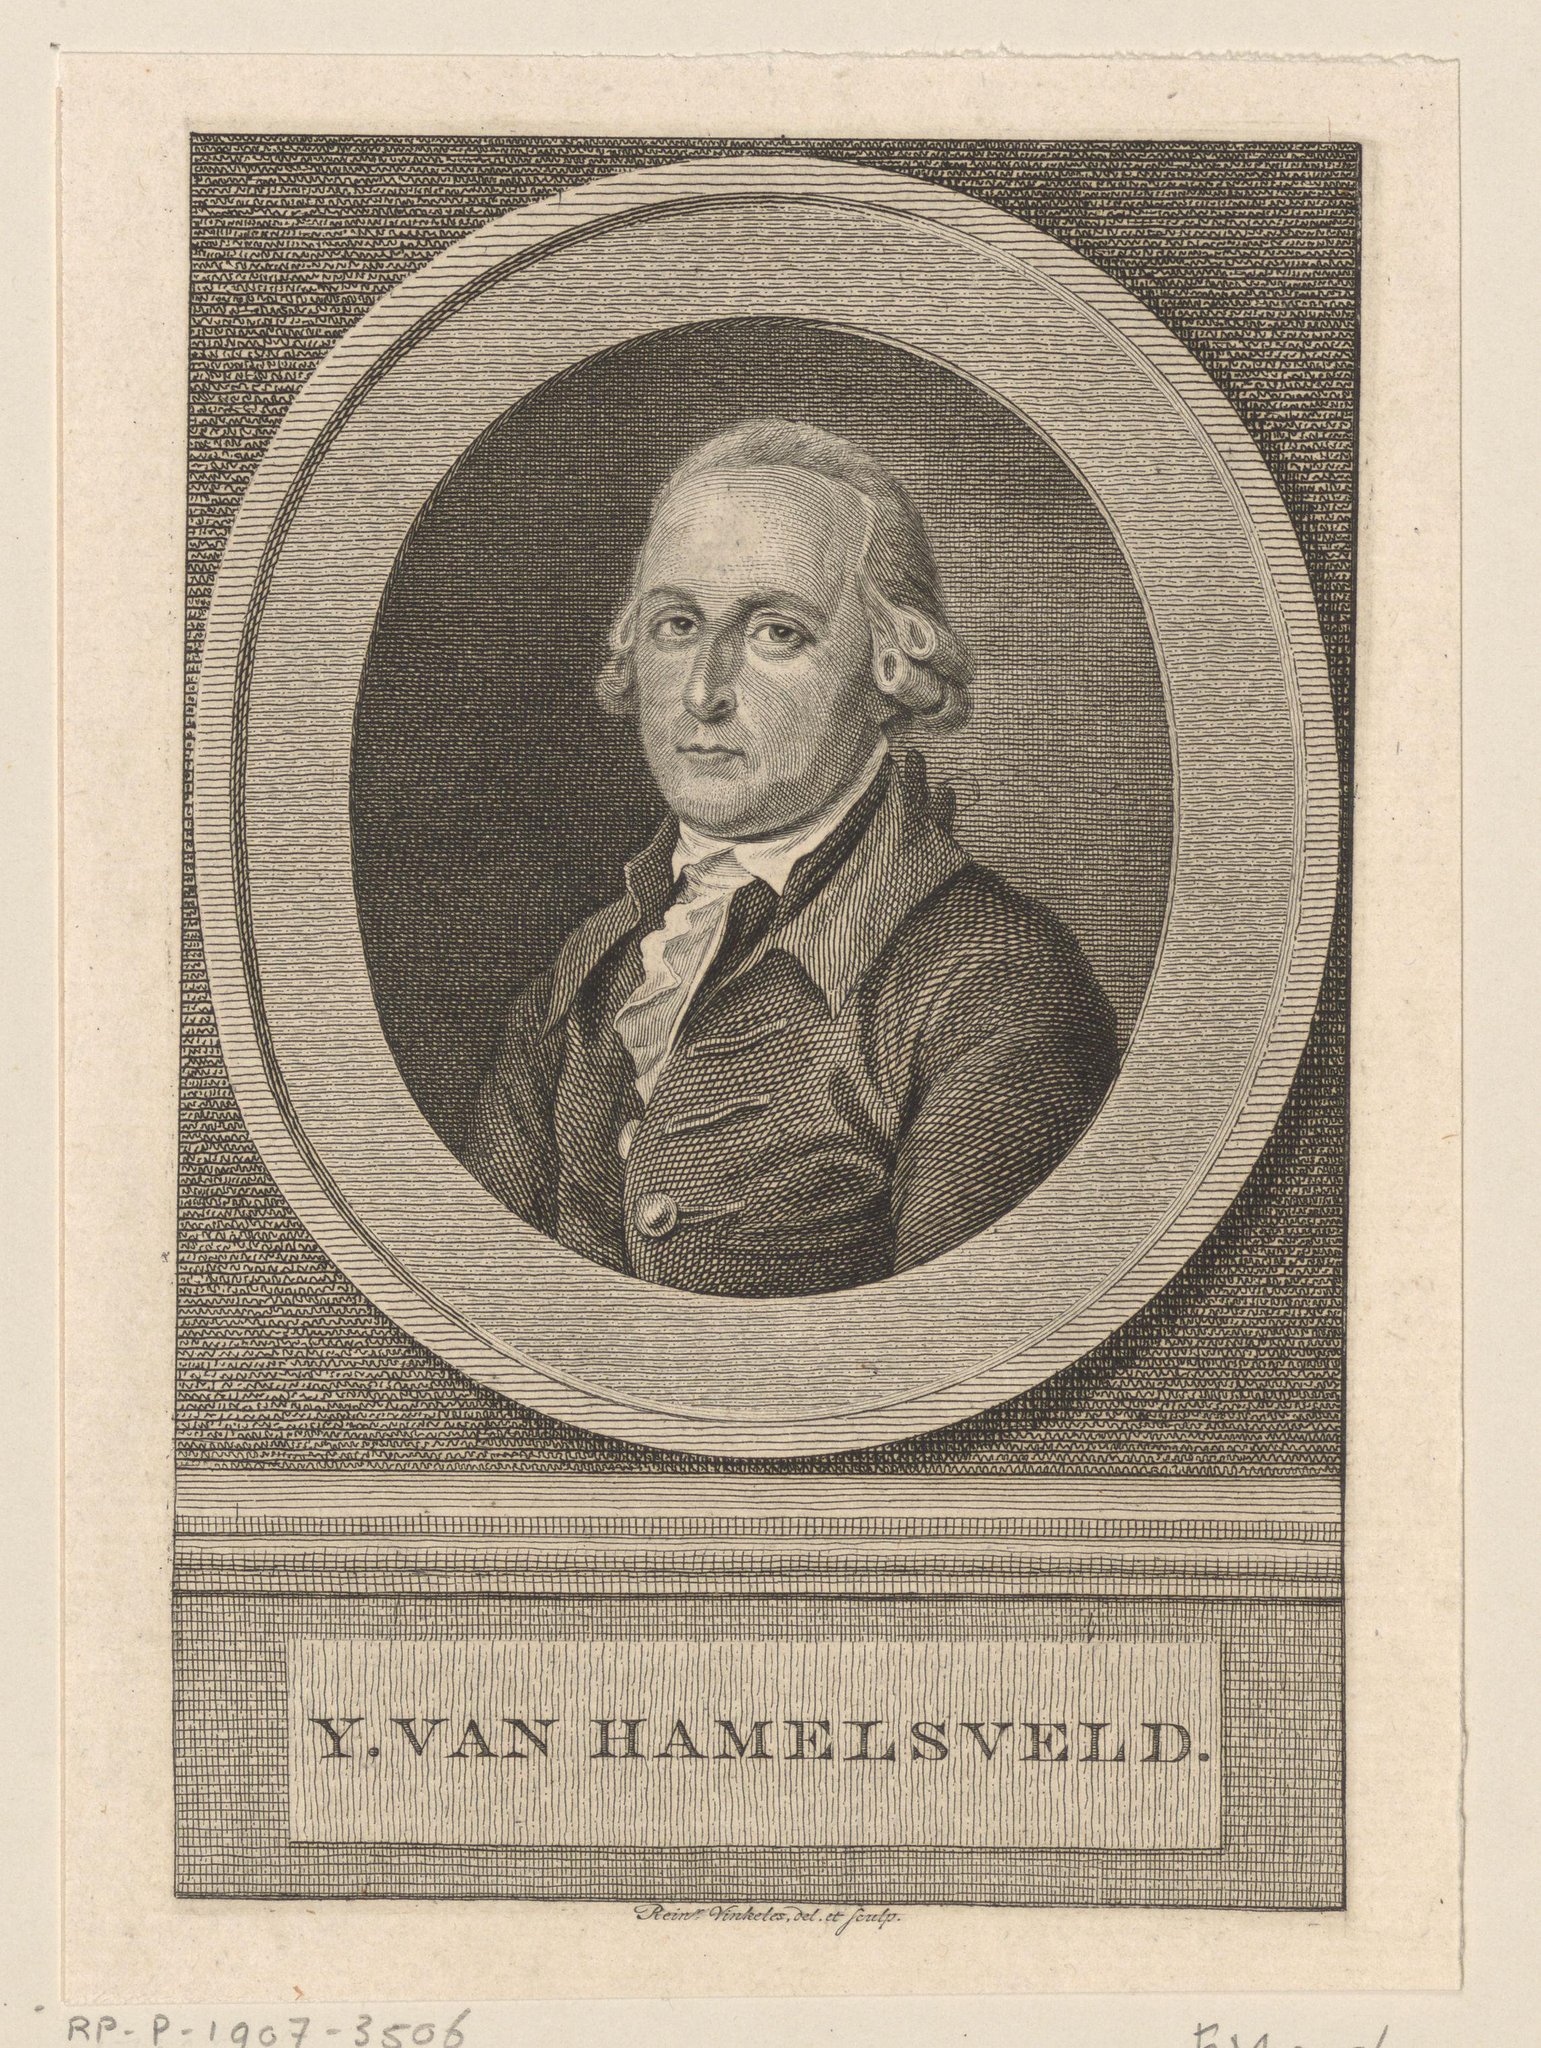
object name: print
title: Portret van IJsbrand van Hamelsveld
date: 1798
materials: paper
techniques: engraving, etching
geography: amsterdam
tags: amsterdam, ijsbrand van hamelsveld, historical persons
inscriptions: collector's mark: Lugt 2228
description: Prent uit: Loosjes, Petrus. Vaderlandsche historie, (...) ten vervolge van Wagenaars Vaderlandsche historie. Amsterdam: Johannes Allart, 1798, dl. 21.